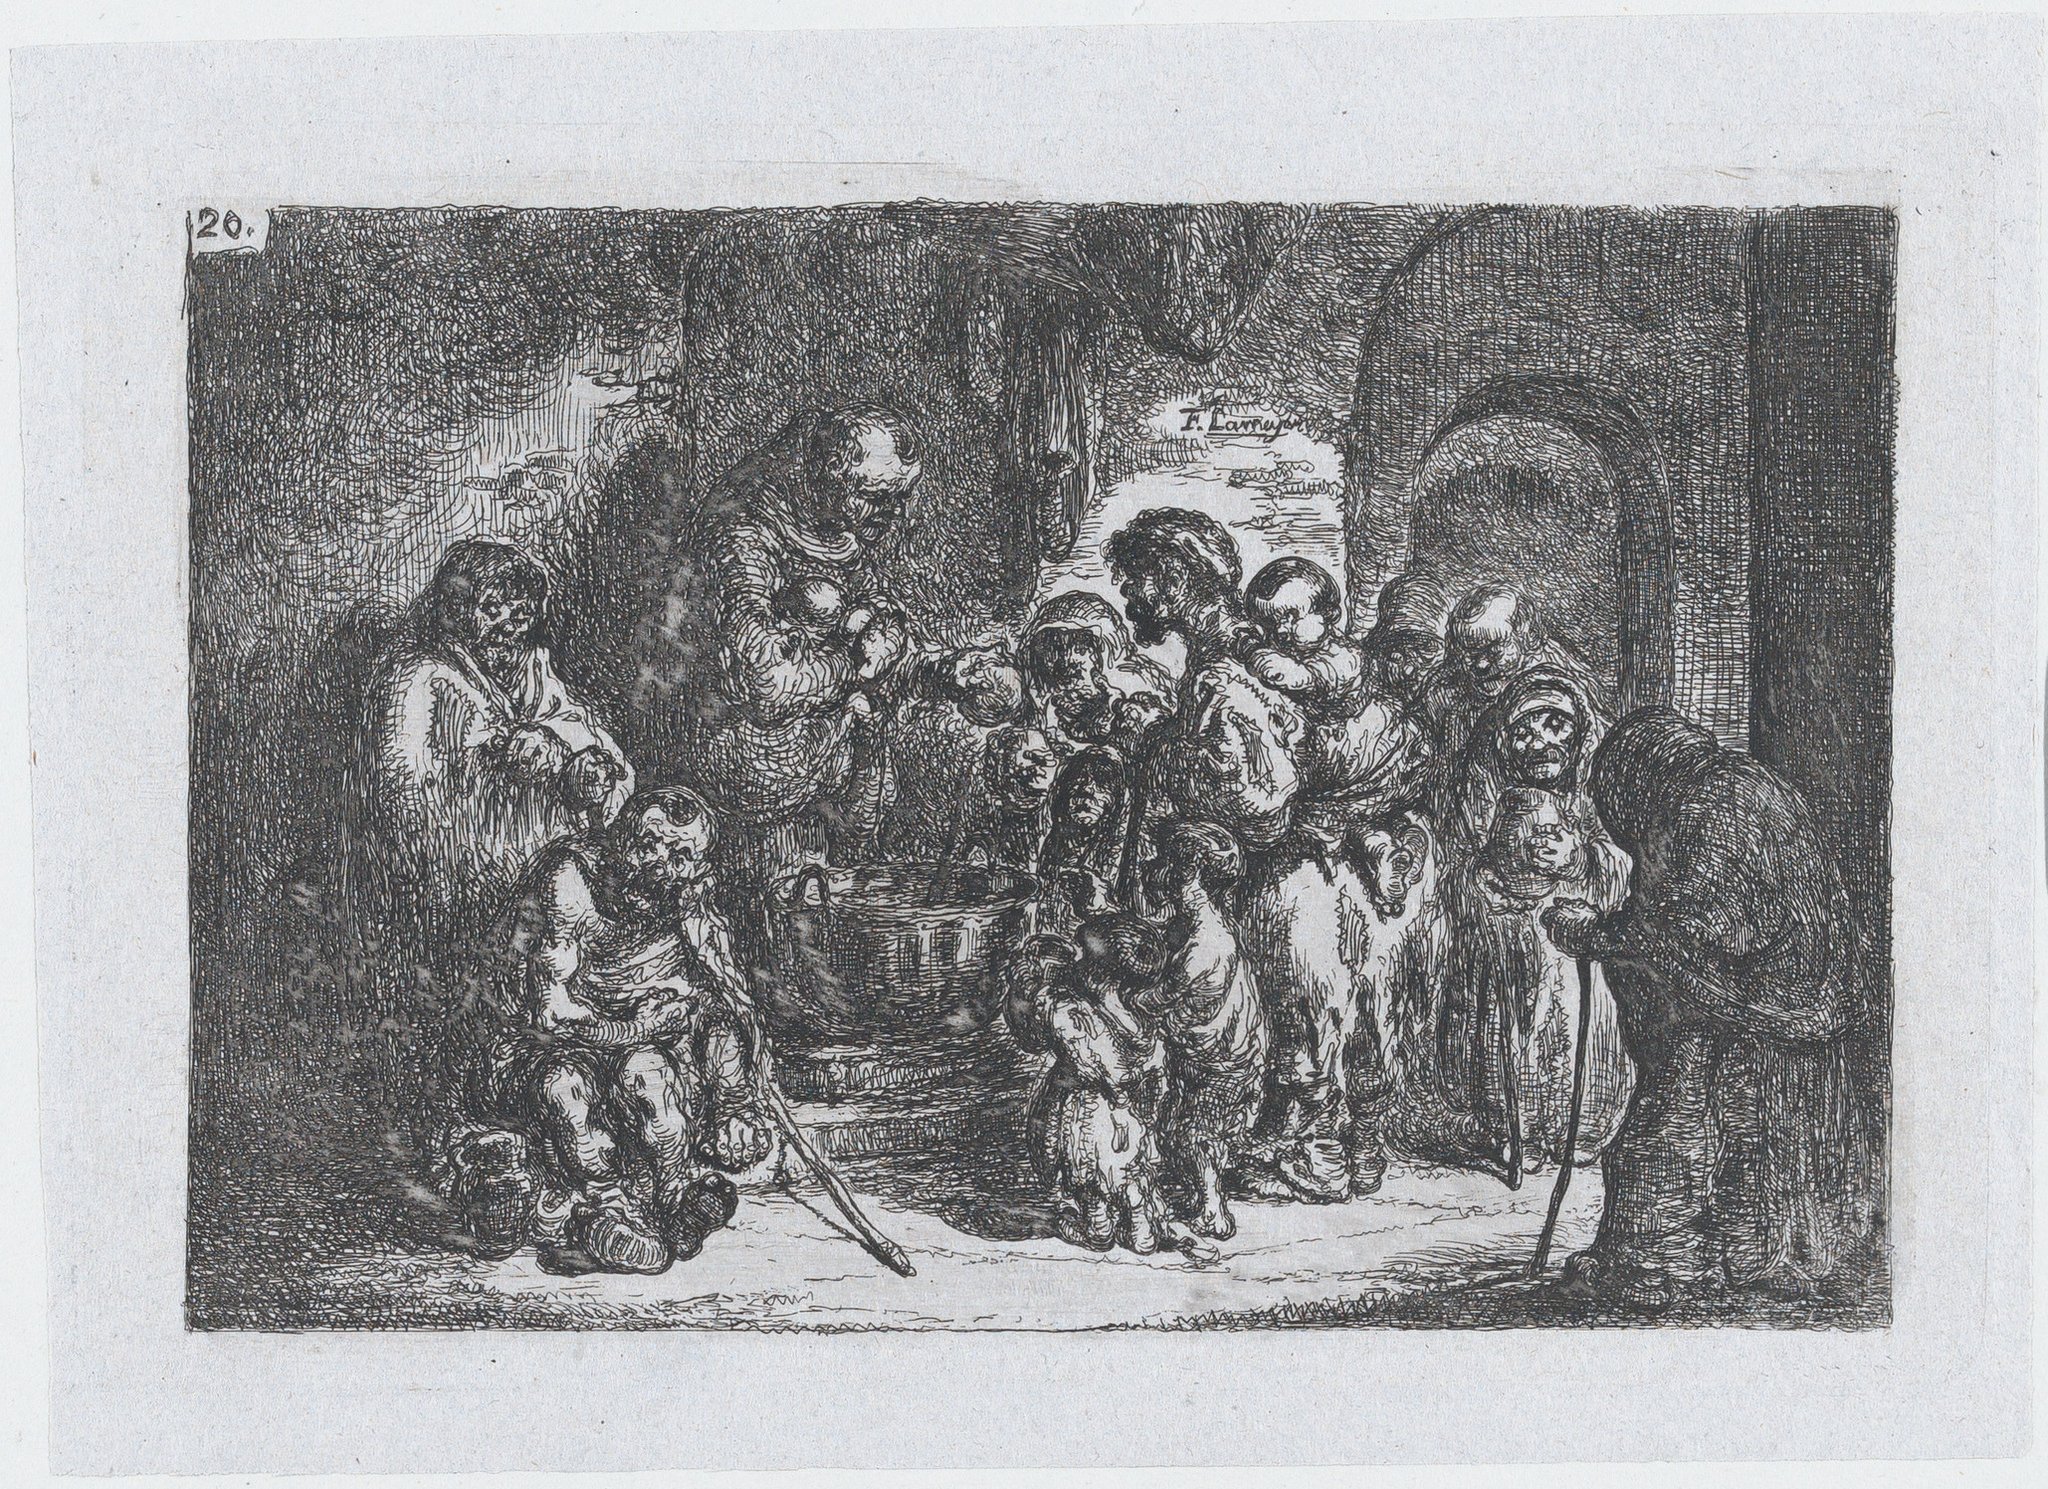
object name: print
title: Plate 20: a priest giving food to the poor, from the series of customs and pastimes of the Spanish people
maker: francisco lameyer y berenguer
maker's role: artist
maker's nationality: spanish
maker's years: 1825-1877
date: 1850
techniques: etching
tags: children,men,women